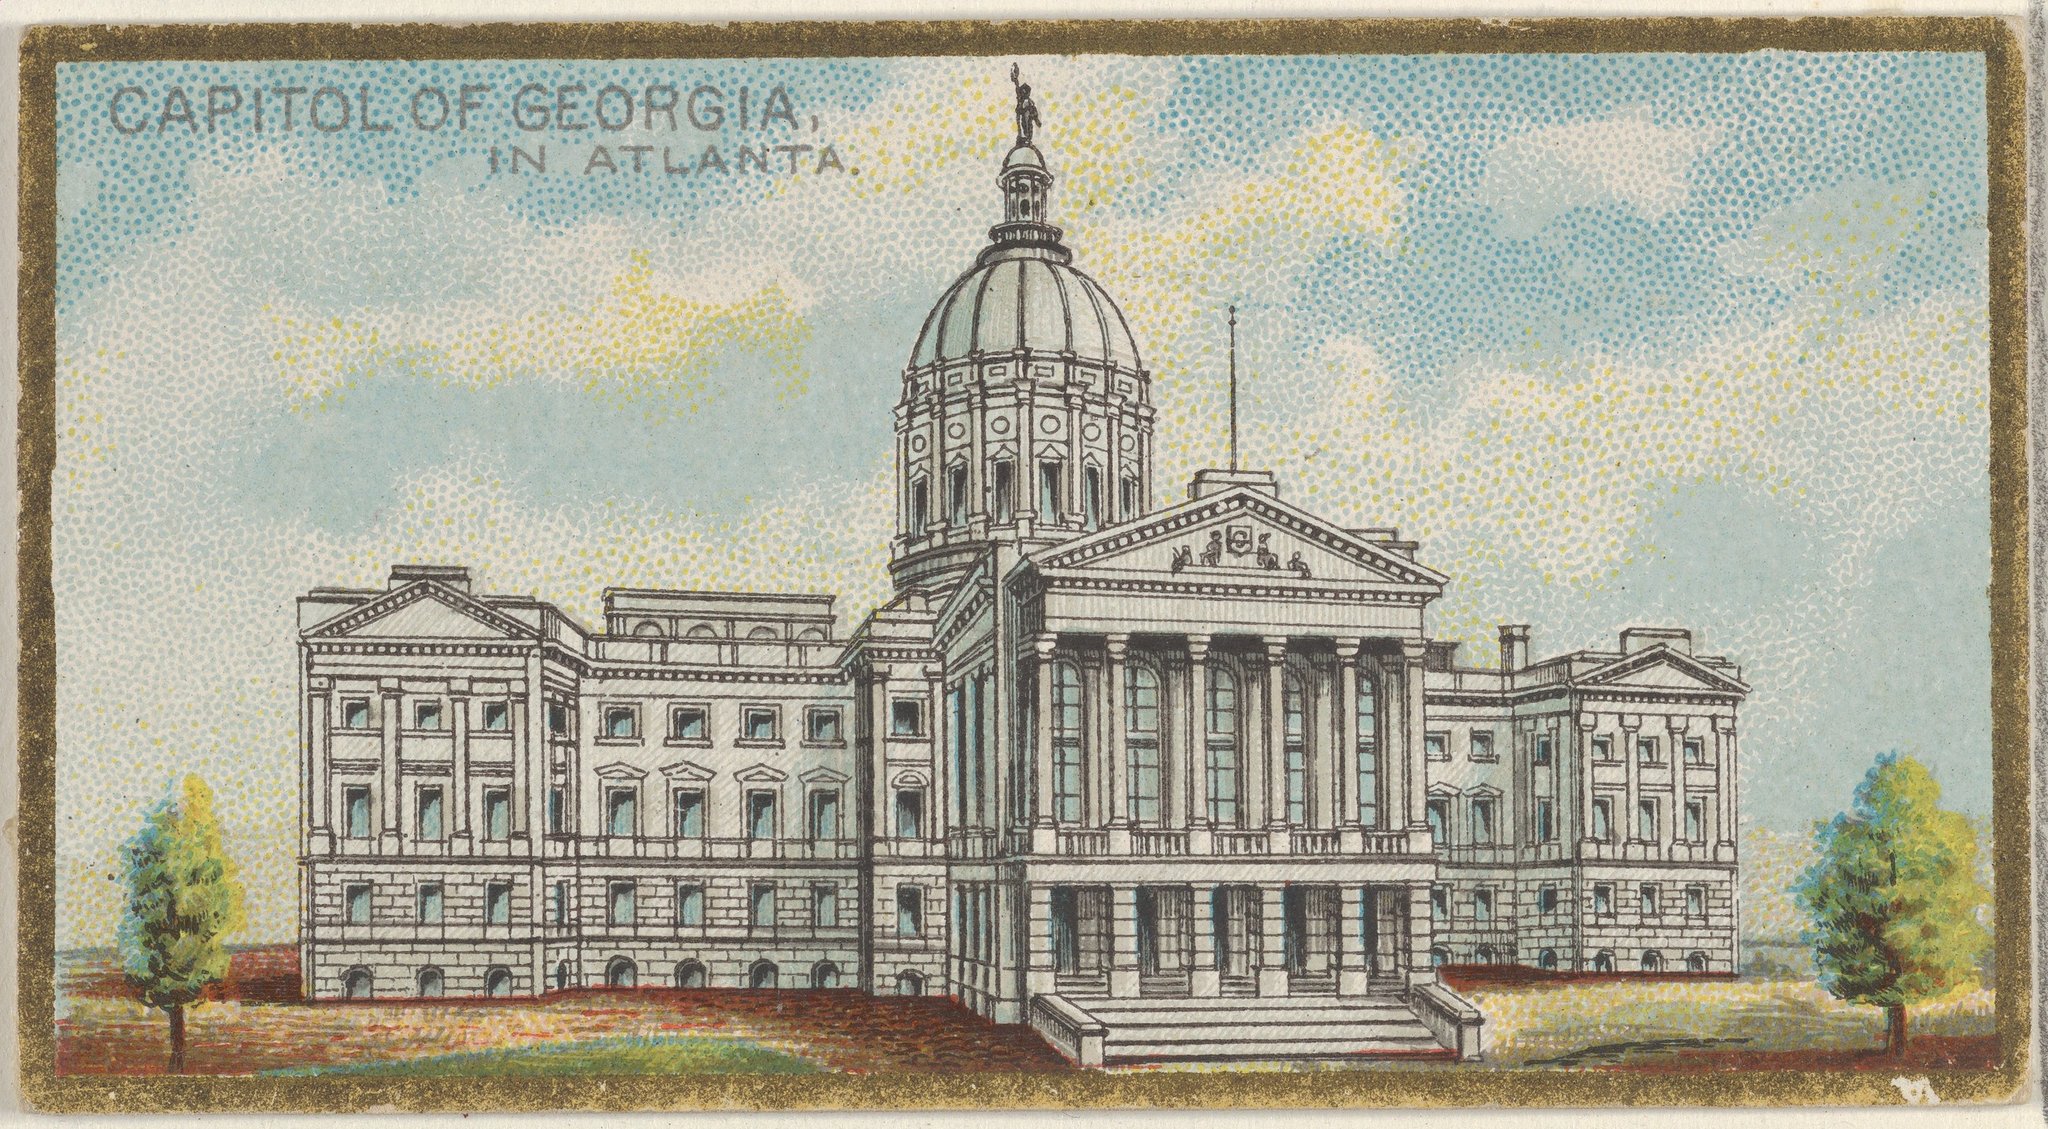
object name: print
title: Capitol of Georgia in Atlanta, from the General Government and State Capitol Buildings series (N14) for Allen & Ginter Cigarettes Brands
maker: allen & ginter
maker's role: publisher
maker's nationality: american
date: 1889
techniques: color lithograph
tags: buildings